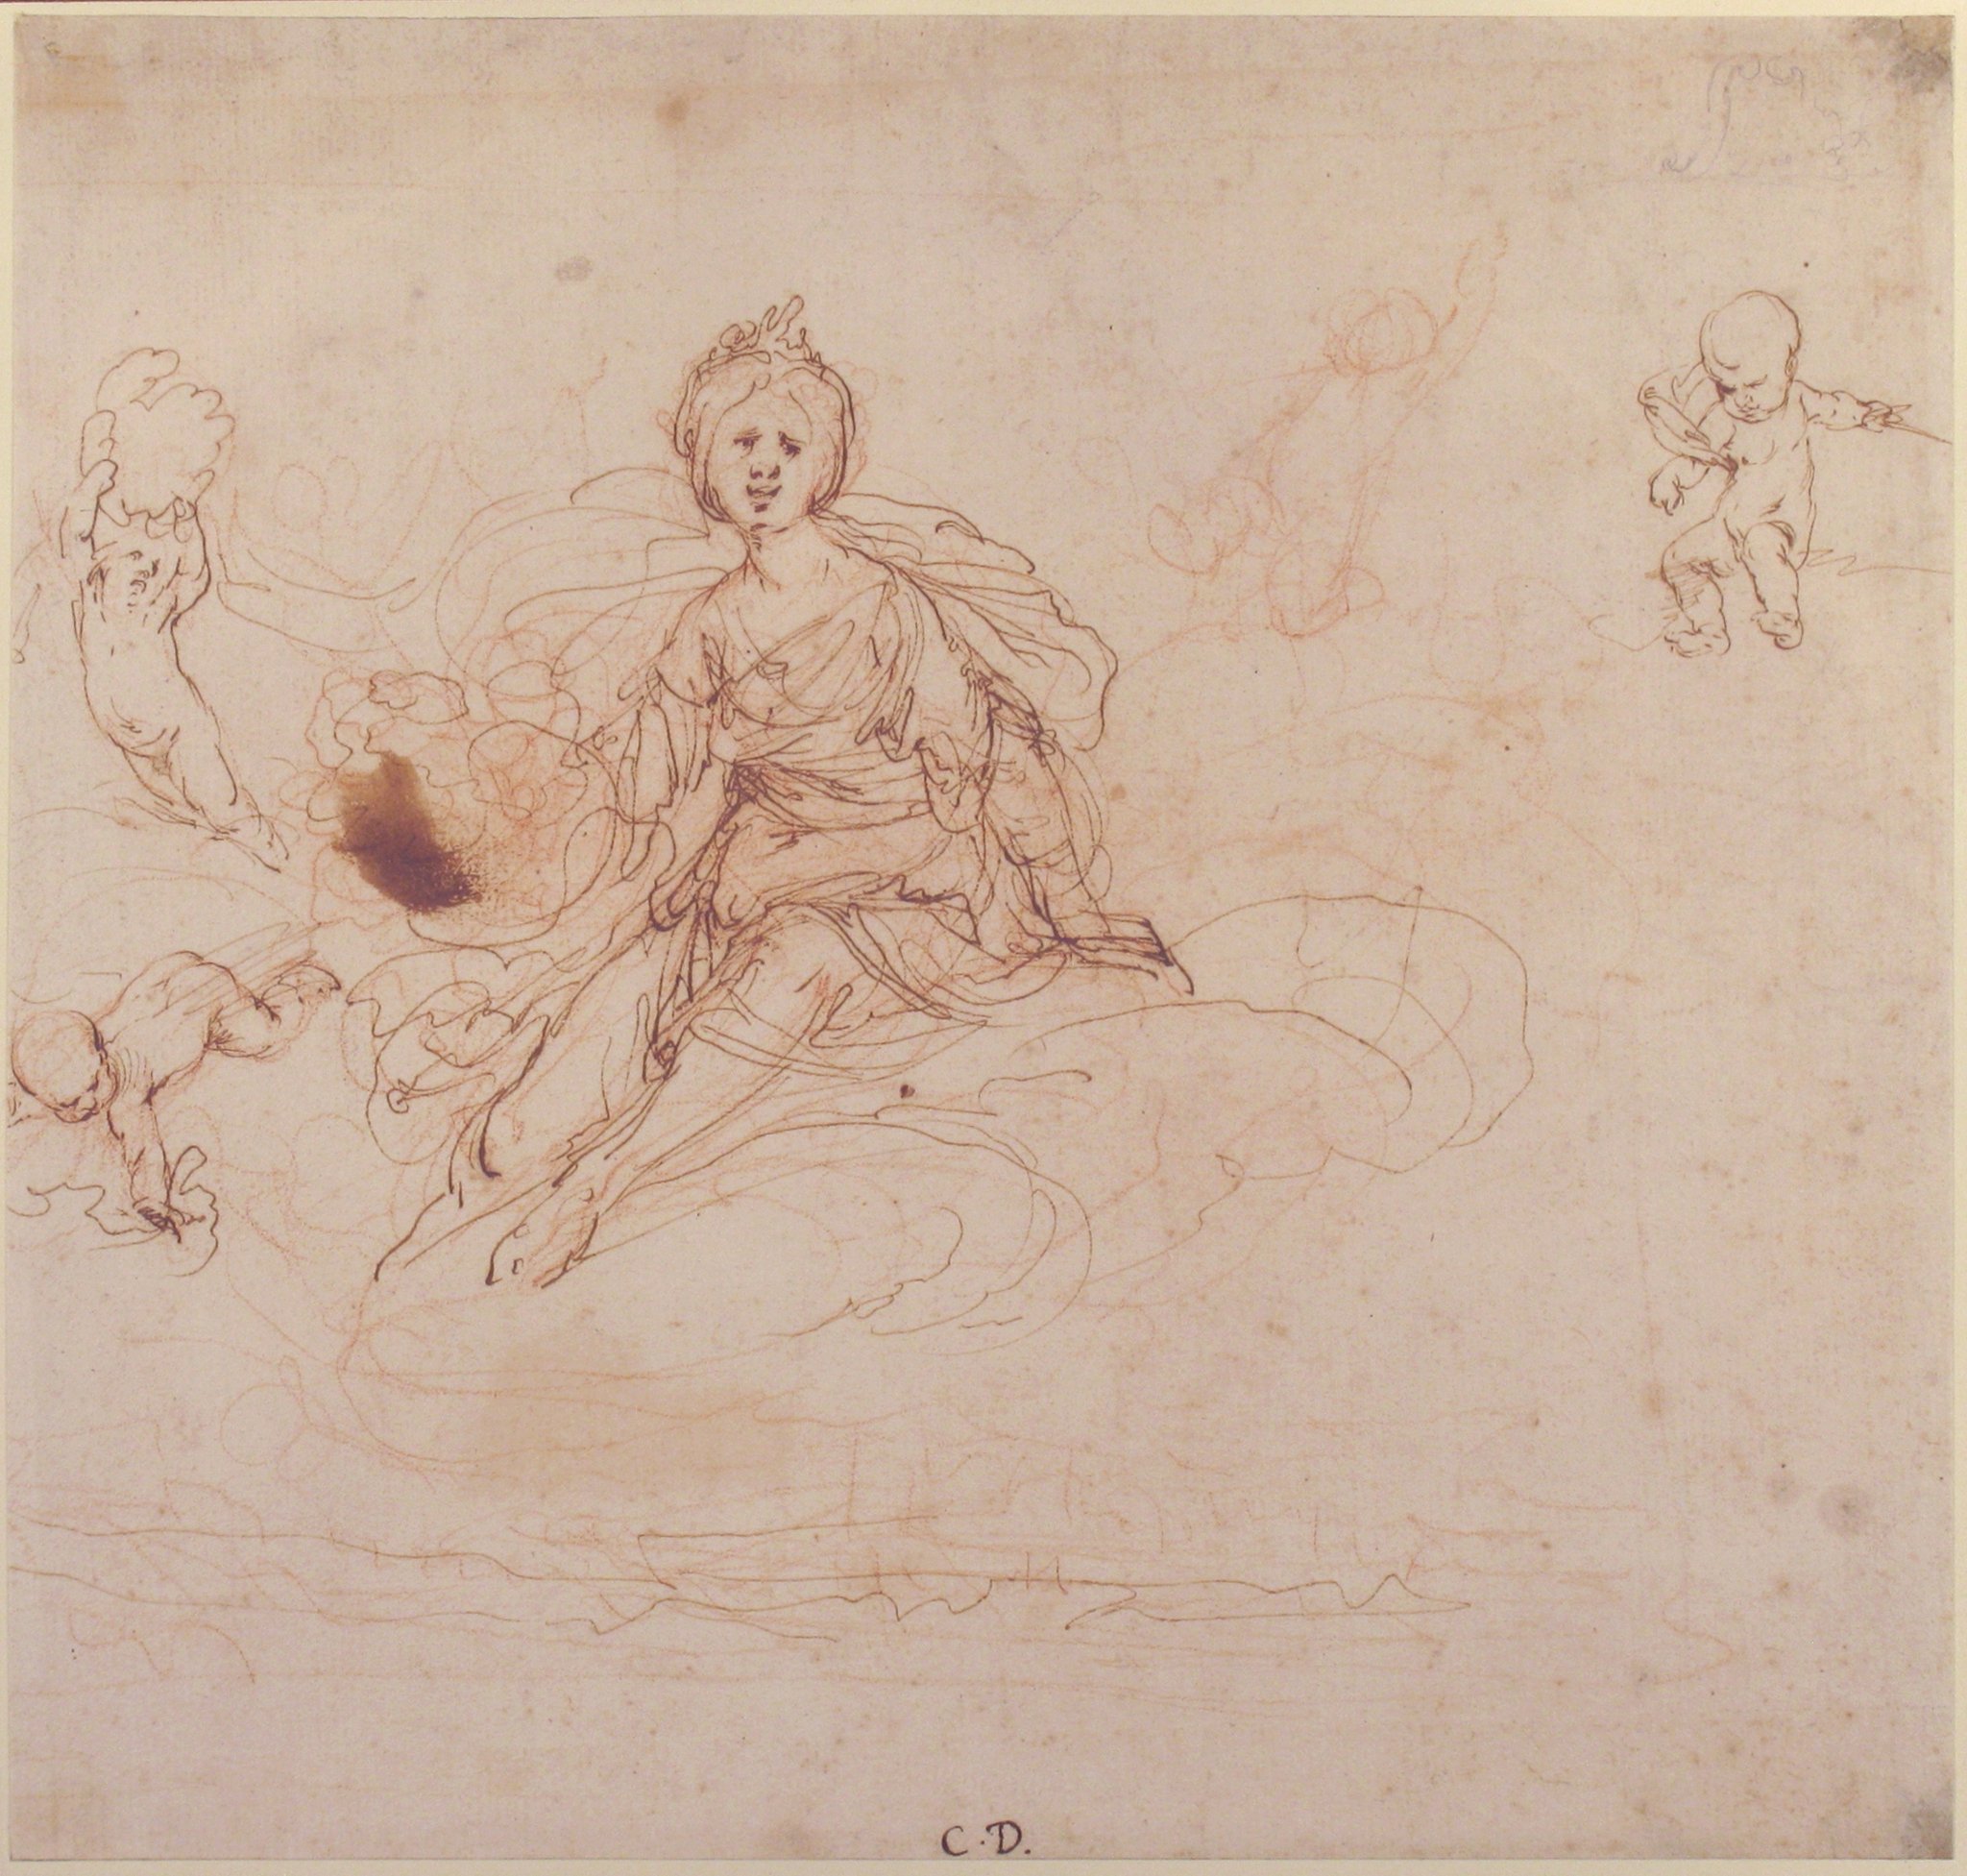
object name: drawing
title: Allegorical Figure of Painting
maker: cesare dandini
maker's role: artist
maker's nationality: italian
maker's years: 1596-1657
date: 1596-1656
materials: chalk, ink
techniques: pen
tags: infants,women